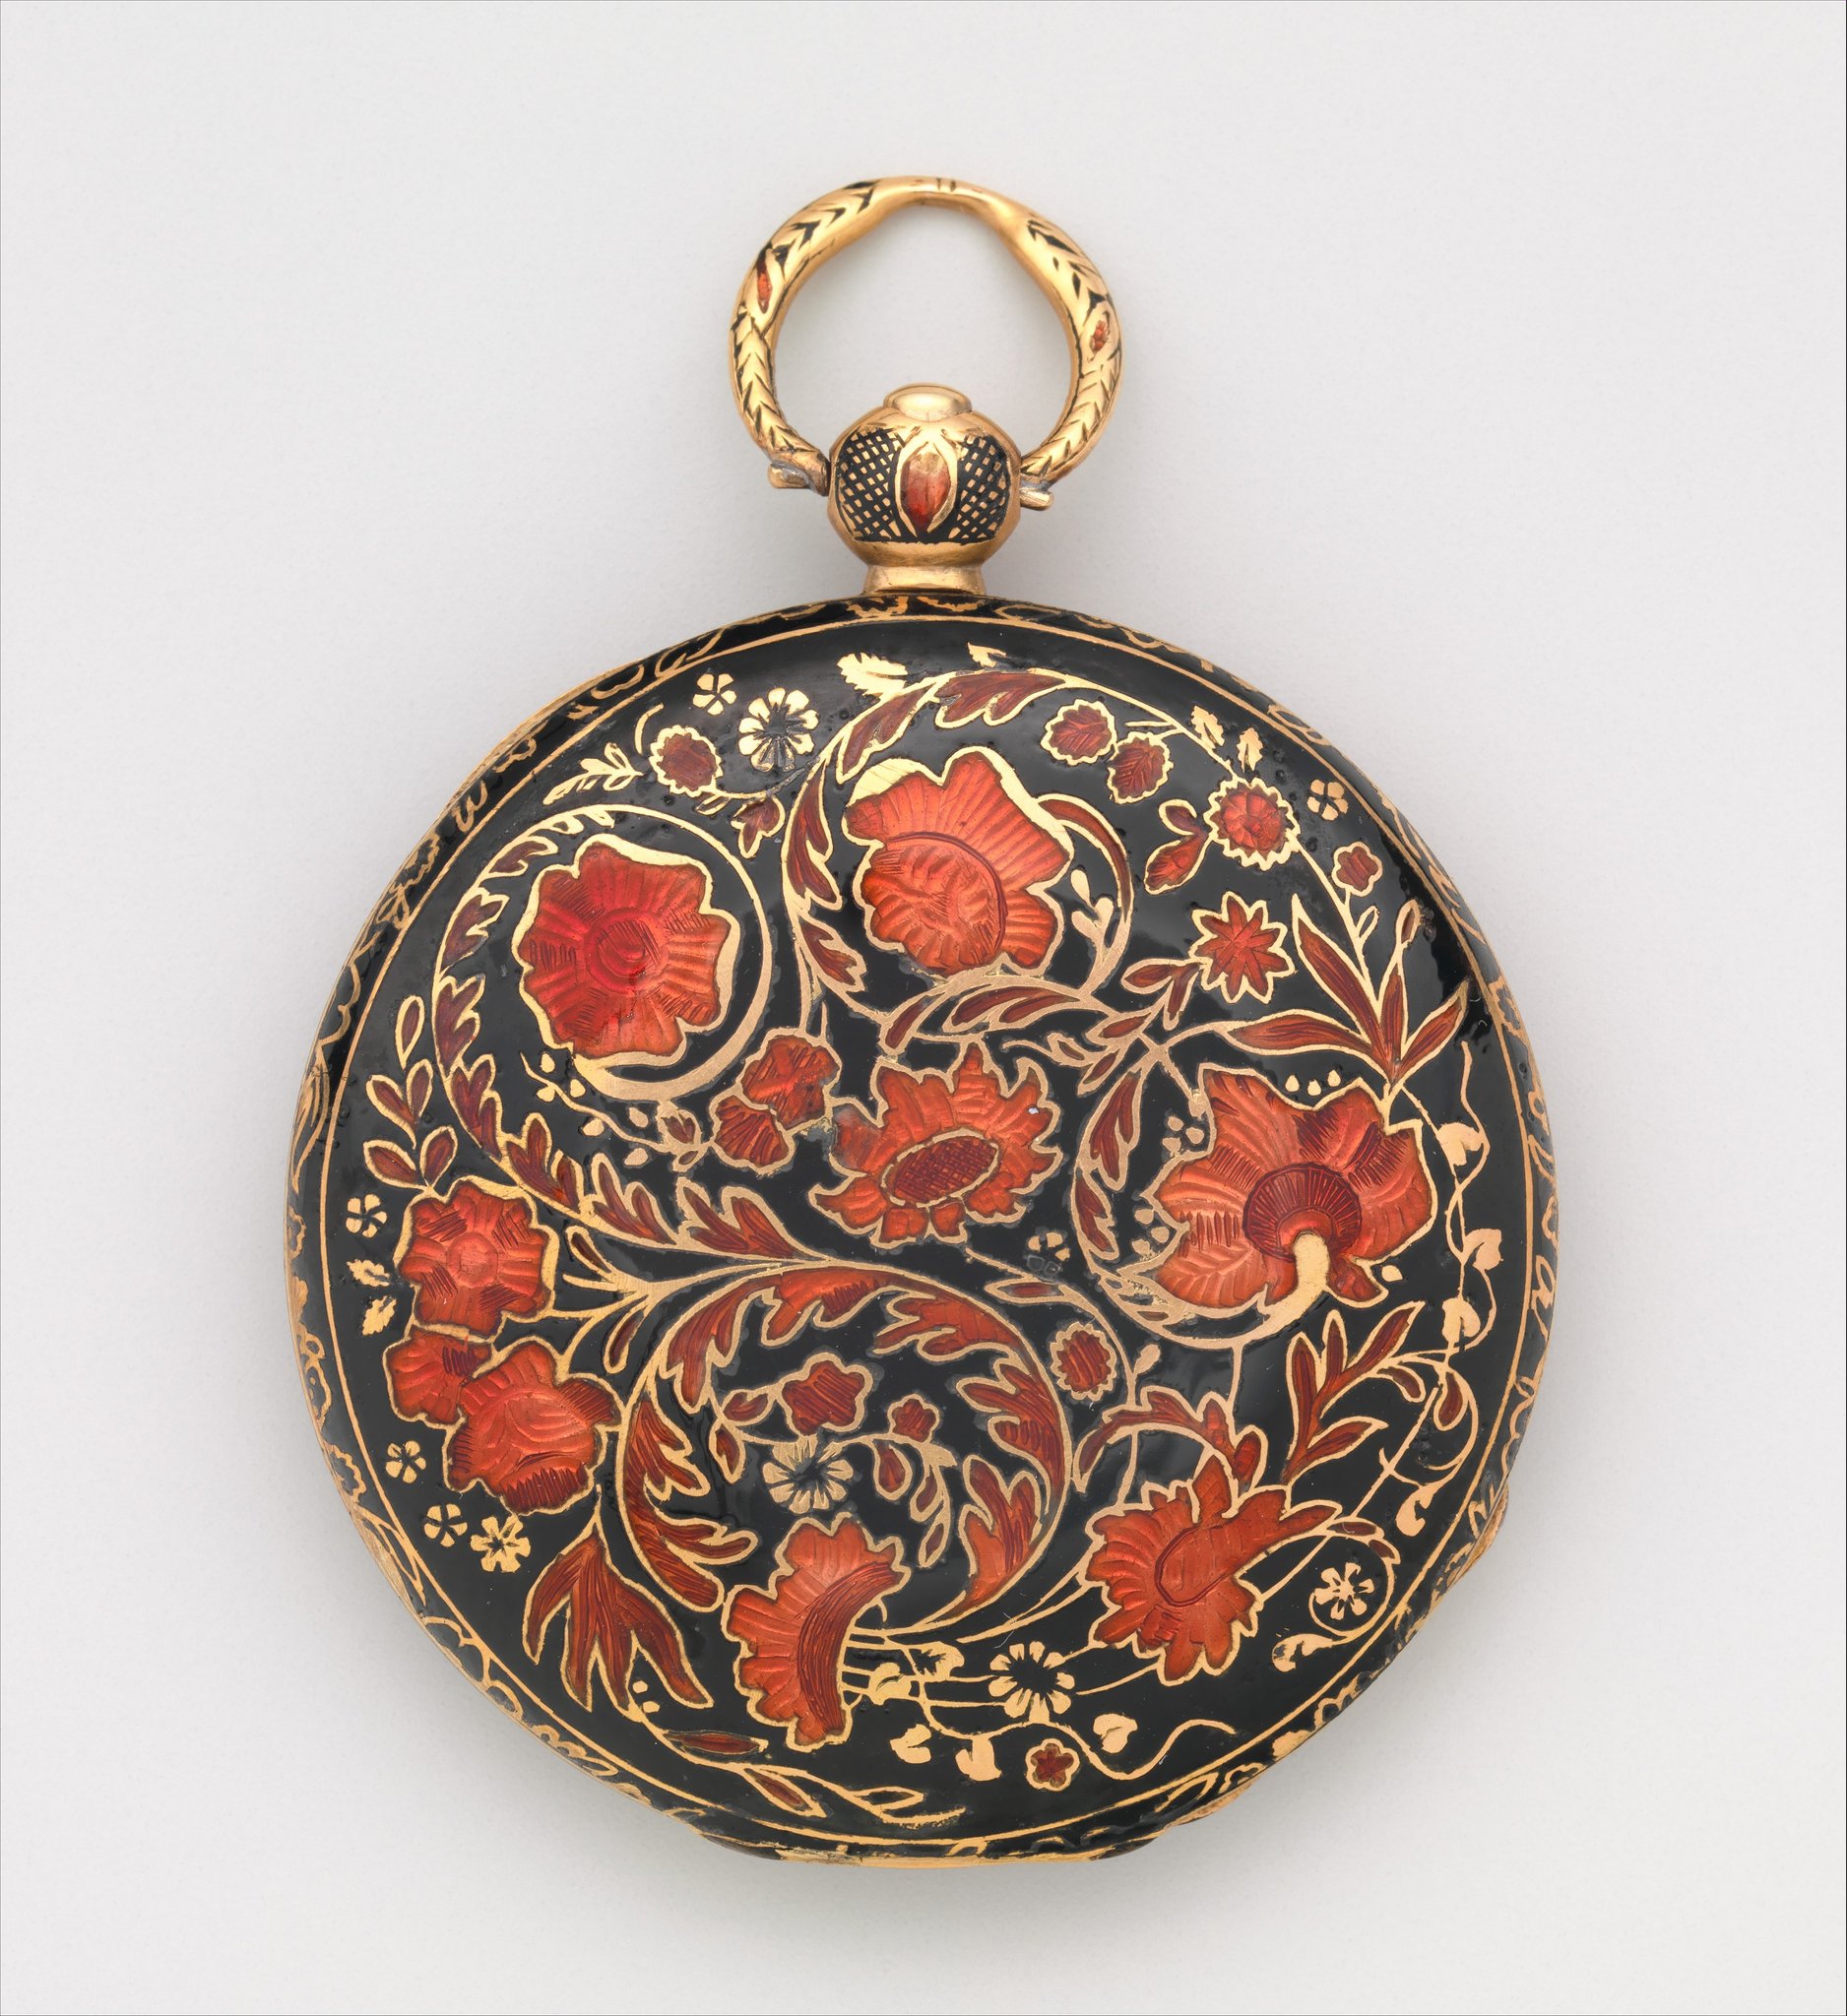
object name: watch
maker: jean-louis moré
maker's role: maker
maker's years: 1810-1835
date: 1830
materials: enamel, gold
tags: flowers,leaves